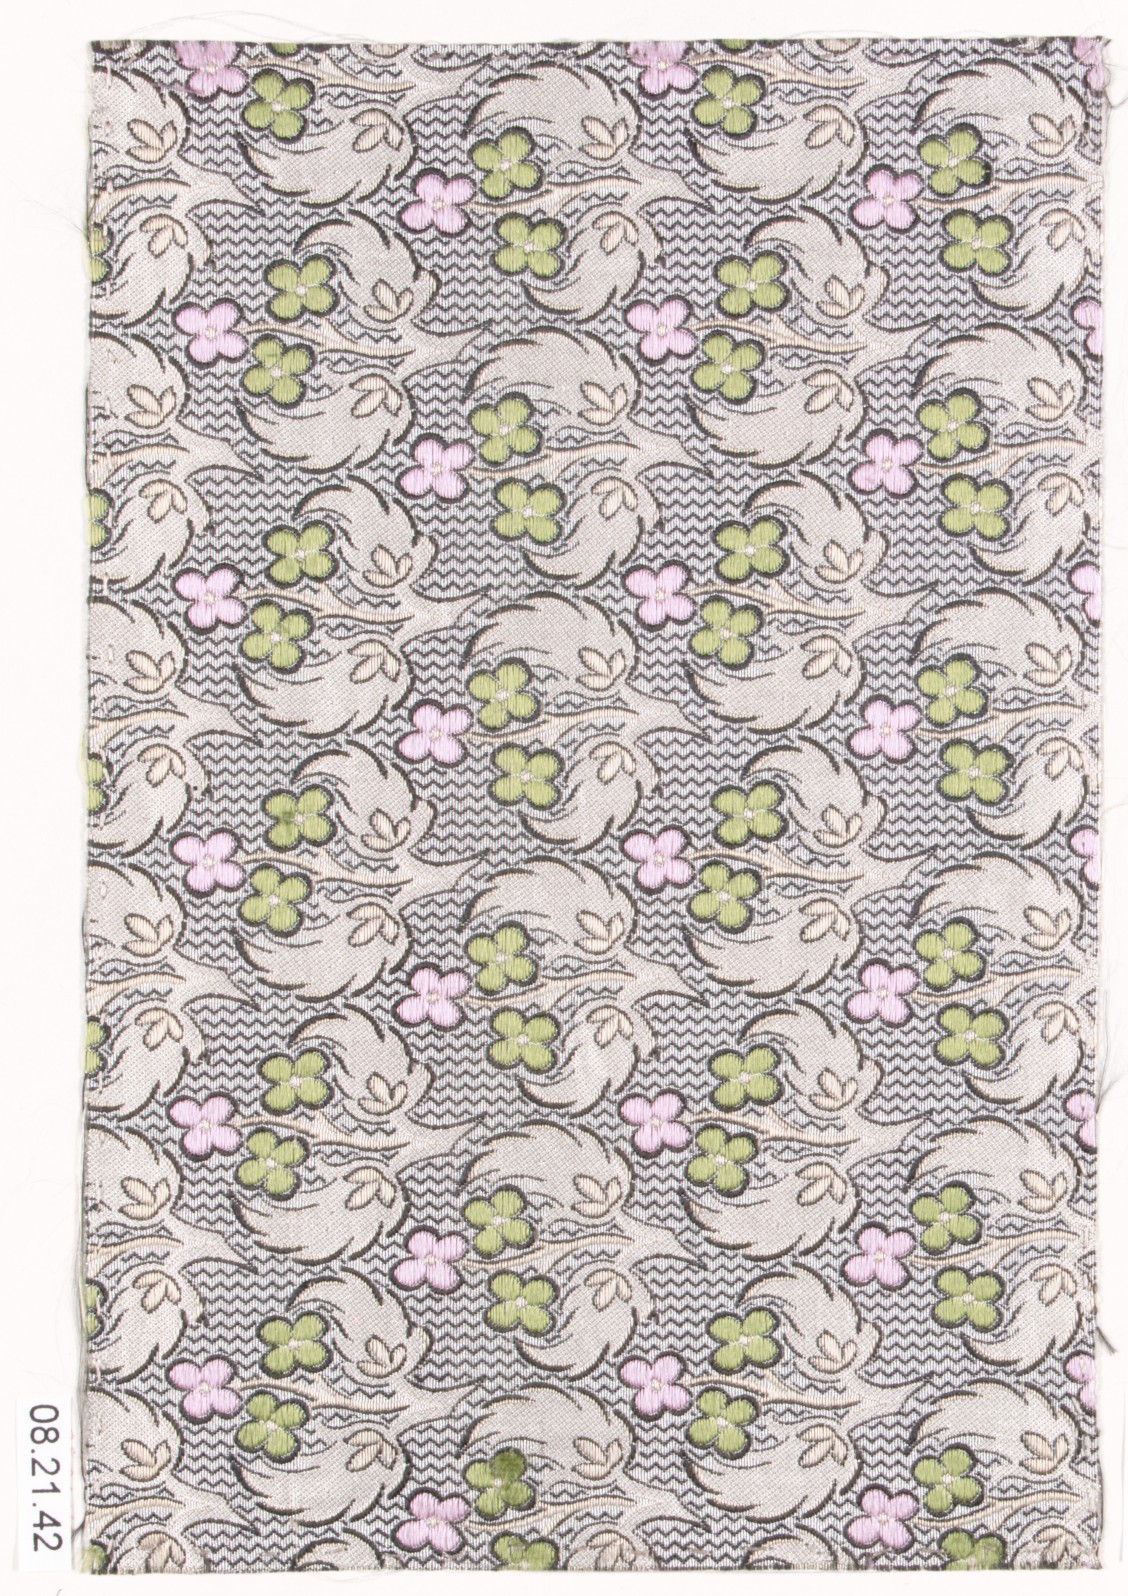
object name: textile sample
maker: Anonymous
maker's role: designer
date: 1900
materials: silk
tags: flowers